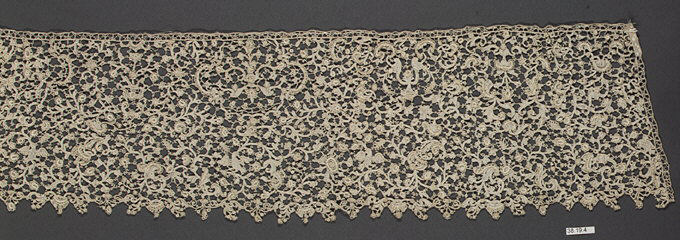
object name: border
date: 1667-1733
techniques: lace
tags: flowers